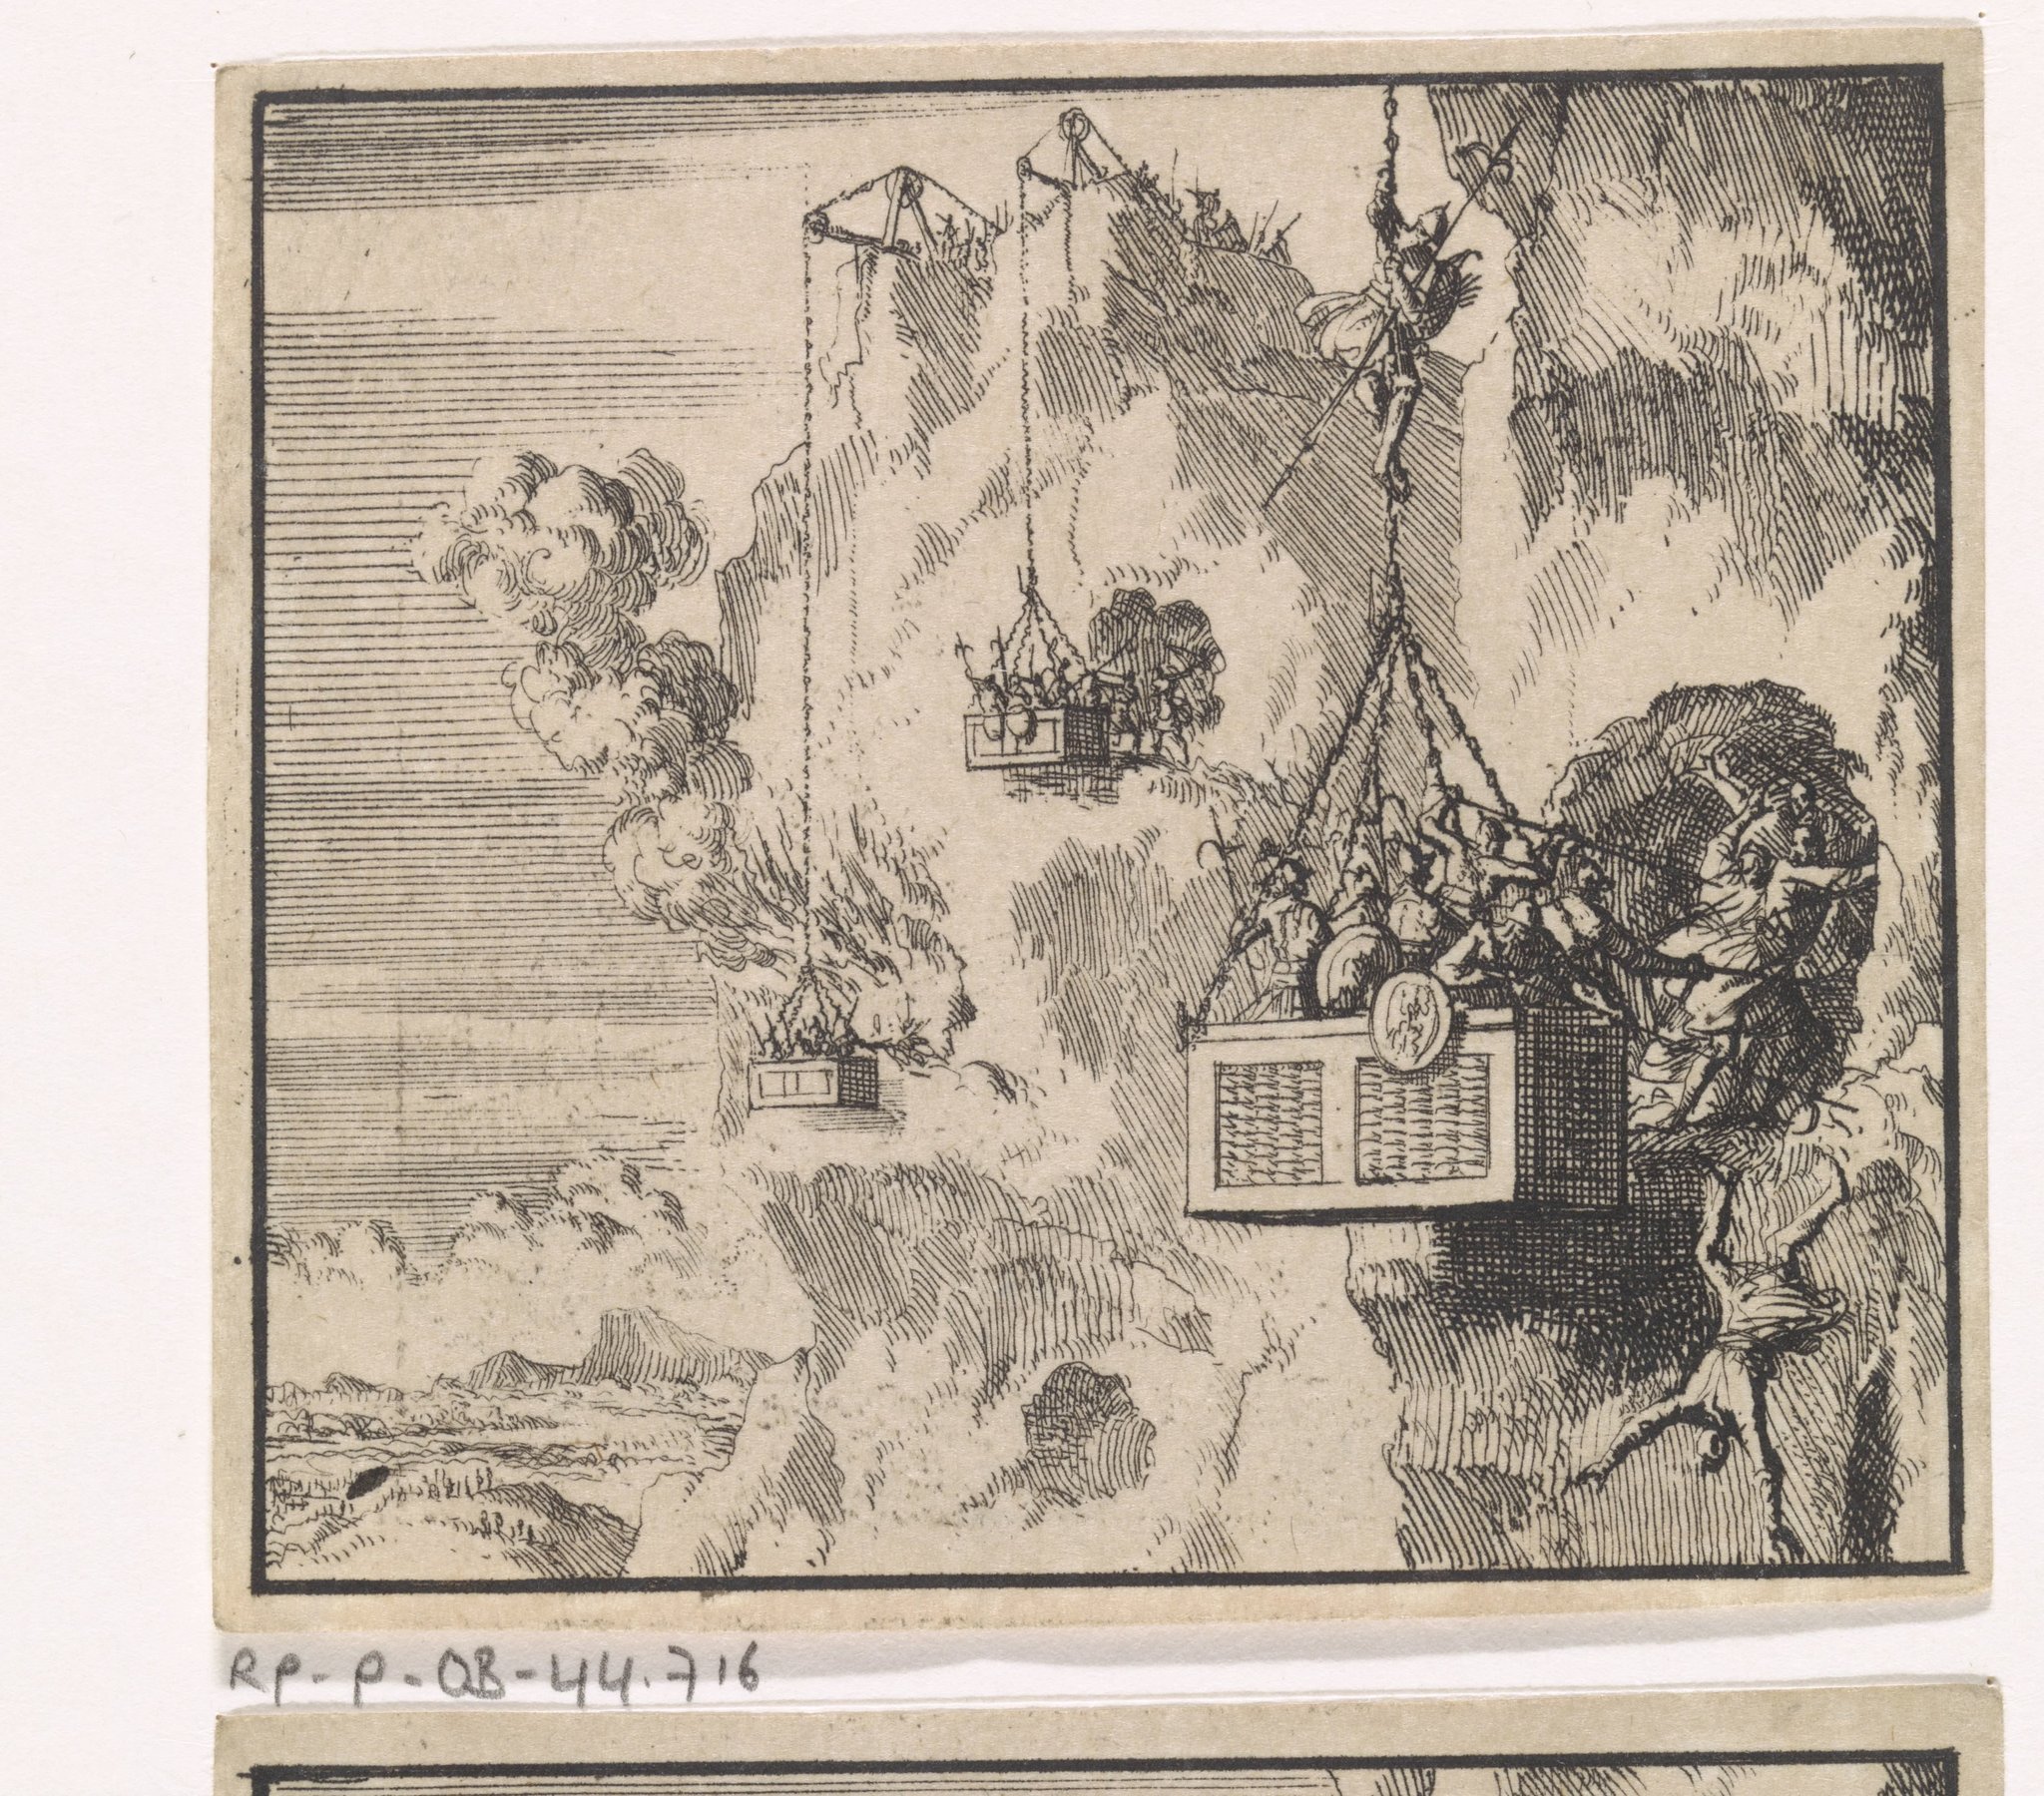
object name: print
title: Koning Herodes bestrijdt rovers die zich in spelonken hebben verscholen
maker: jan luyken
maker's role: draughtsman, print maker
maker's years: 1649-1712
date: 1698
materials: paper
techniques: etching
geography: amsterdam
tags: robber, cave, grotto, male persons from classical history (herod)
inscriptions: collector's mark: Lugt 2228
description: Proefdruk van illustratie uit: Josephus, Flavius. XX. boeken van de oude geschiedenissen der joden, 4 delen. Amsterdam: Barent Visscher, Willem de Coup, Willem van Lamsveld, Andries van Damme, 1698, dl. II.